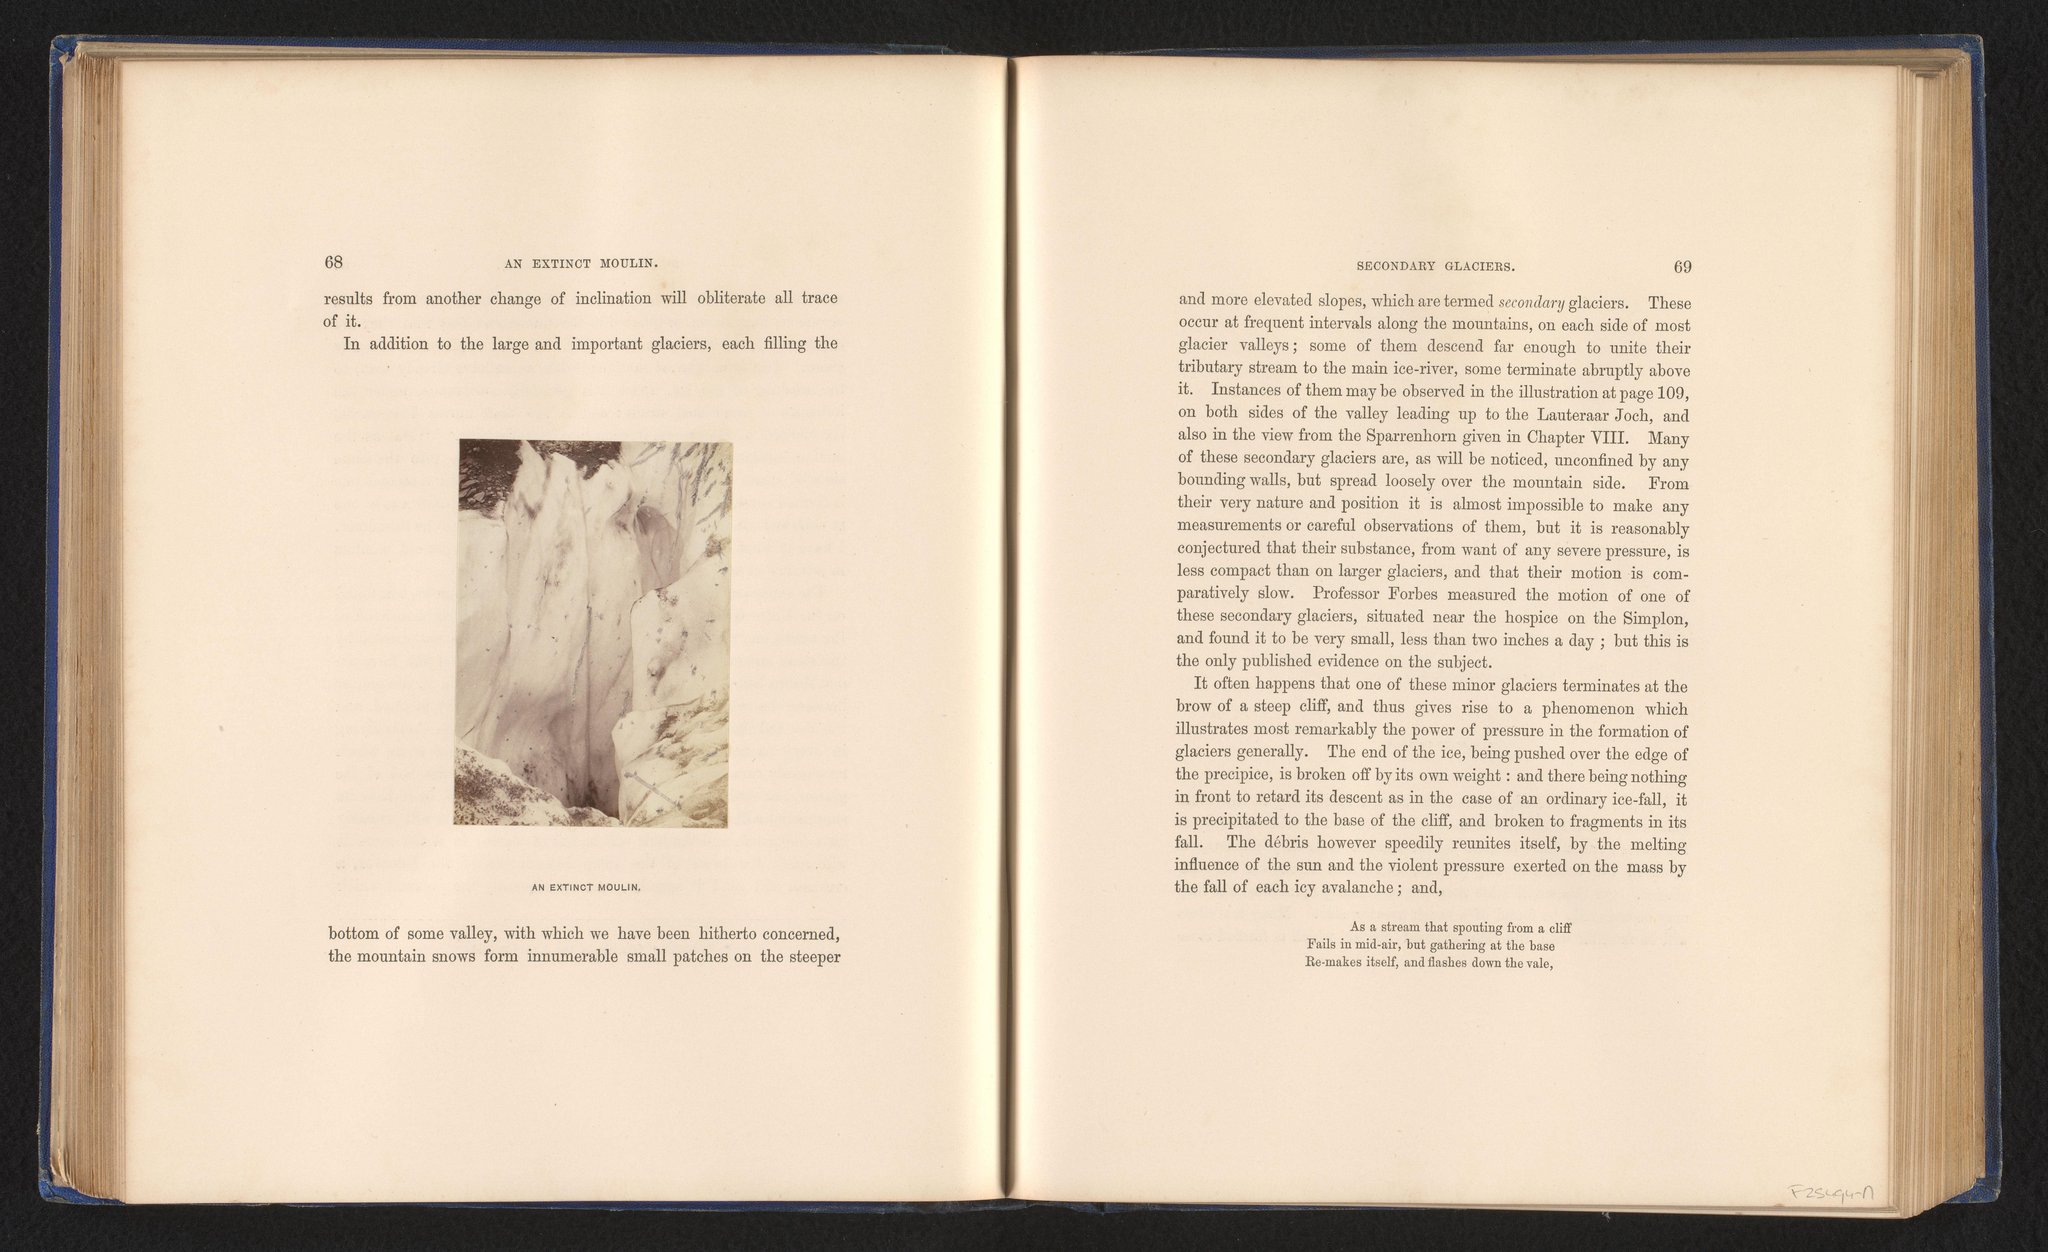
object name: page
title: Voormalige maalstroom in een gletsjer in het Berner Oberland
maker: ernest edwards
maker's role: fotograaf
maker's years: 1837-1903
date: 1861-1866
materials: paper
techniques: albumen print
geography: berner oberland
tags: glacier